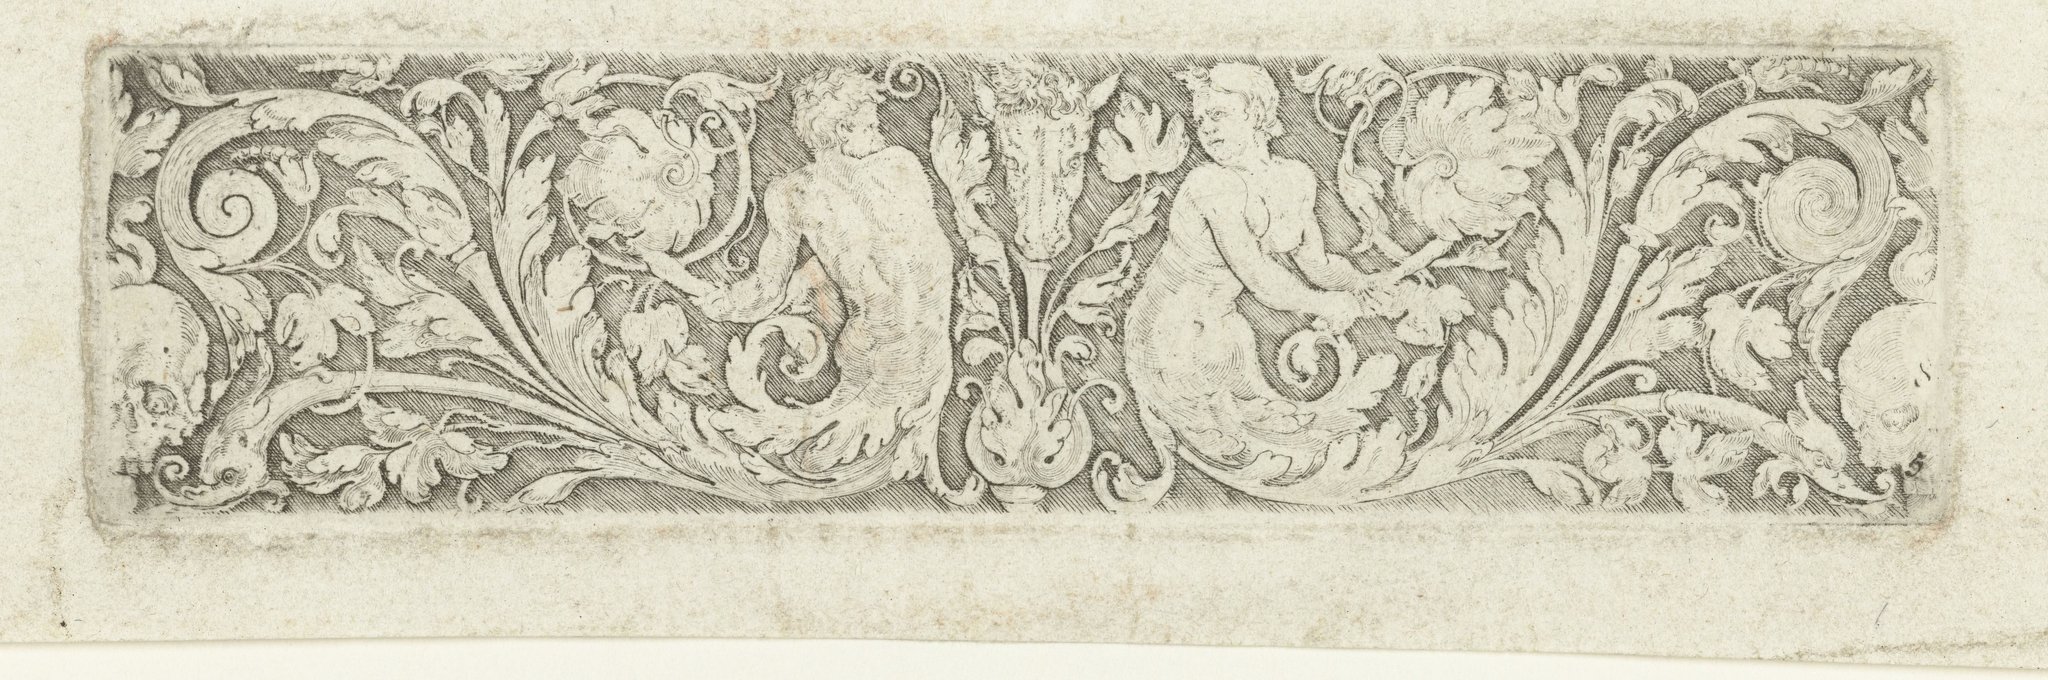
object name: ornament print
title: Ornament met twee tritonen en twee doodshoofden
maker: meester van de paardenhoofden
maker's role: print maker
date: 1500-1599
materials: paper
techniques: engraving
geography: low countries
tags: triton(s), (human) skull, plants; vegetation (+ ornamental variants of plants)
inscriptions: collector's mark: Lugt 2228a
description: Ornament met paardekop en een manlijk en vrouwelijk zeewezen. Plantornamentatie en geheel rechts en links een doodshoofd. Latere staat met linksonder "5" toegevoegd. Niet in literatuur vermeld.